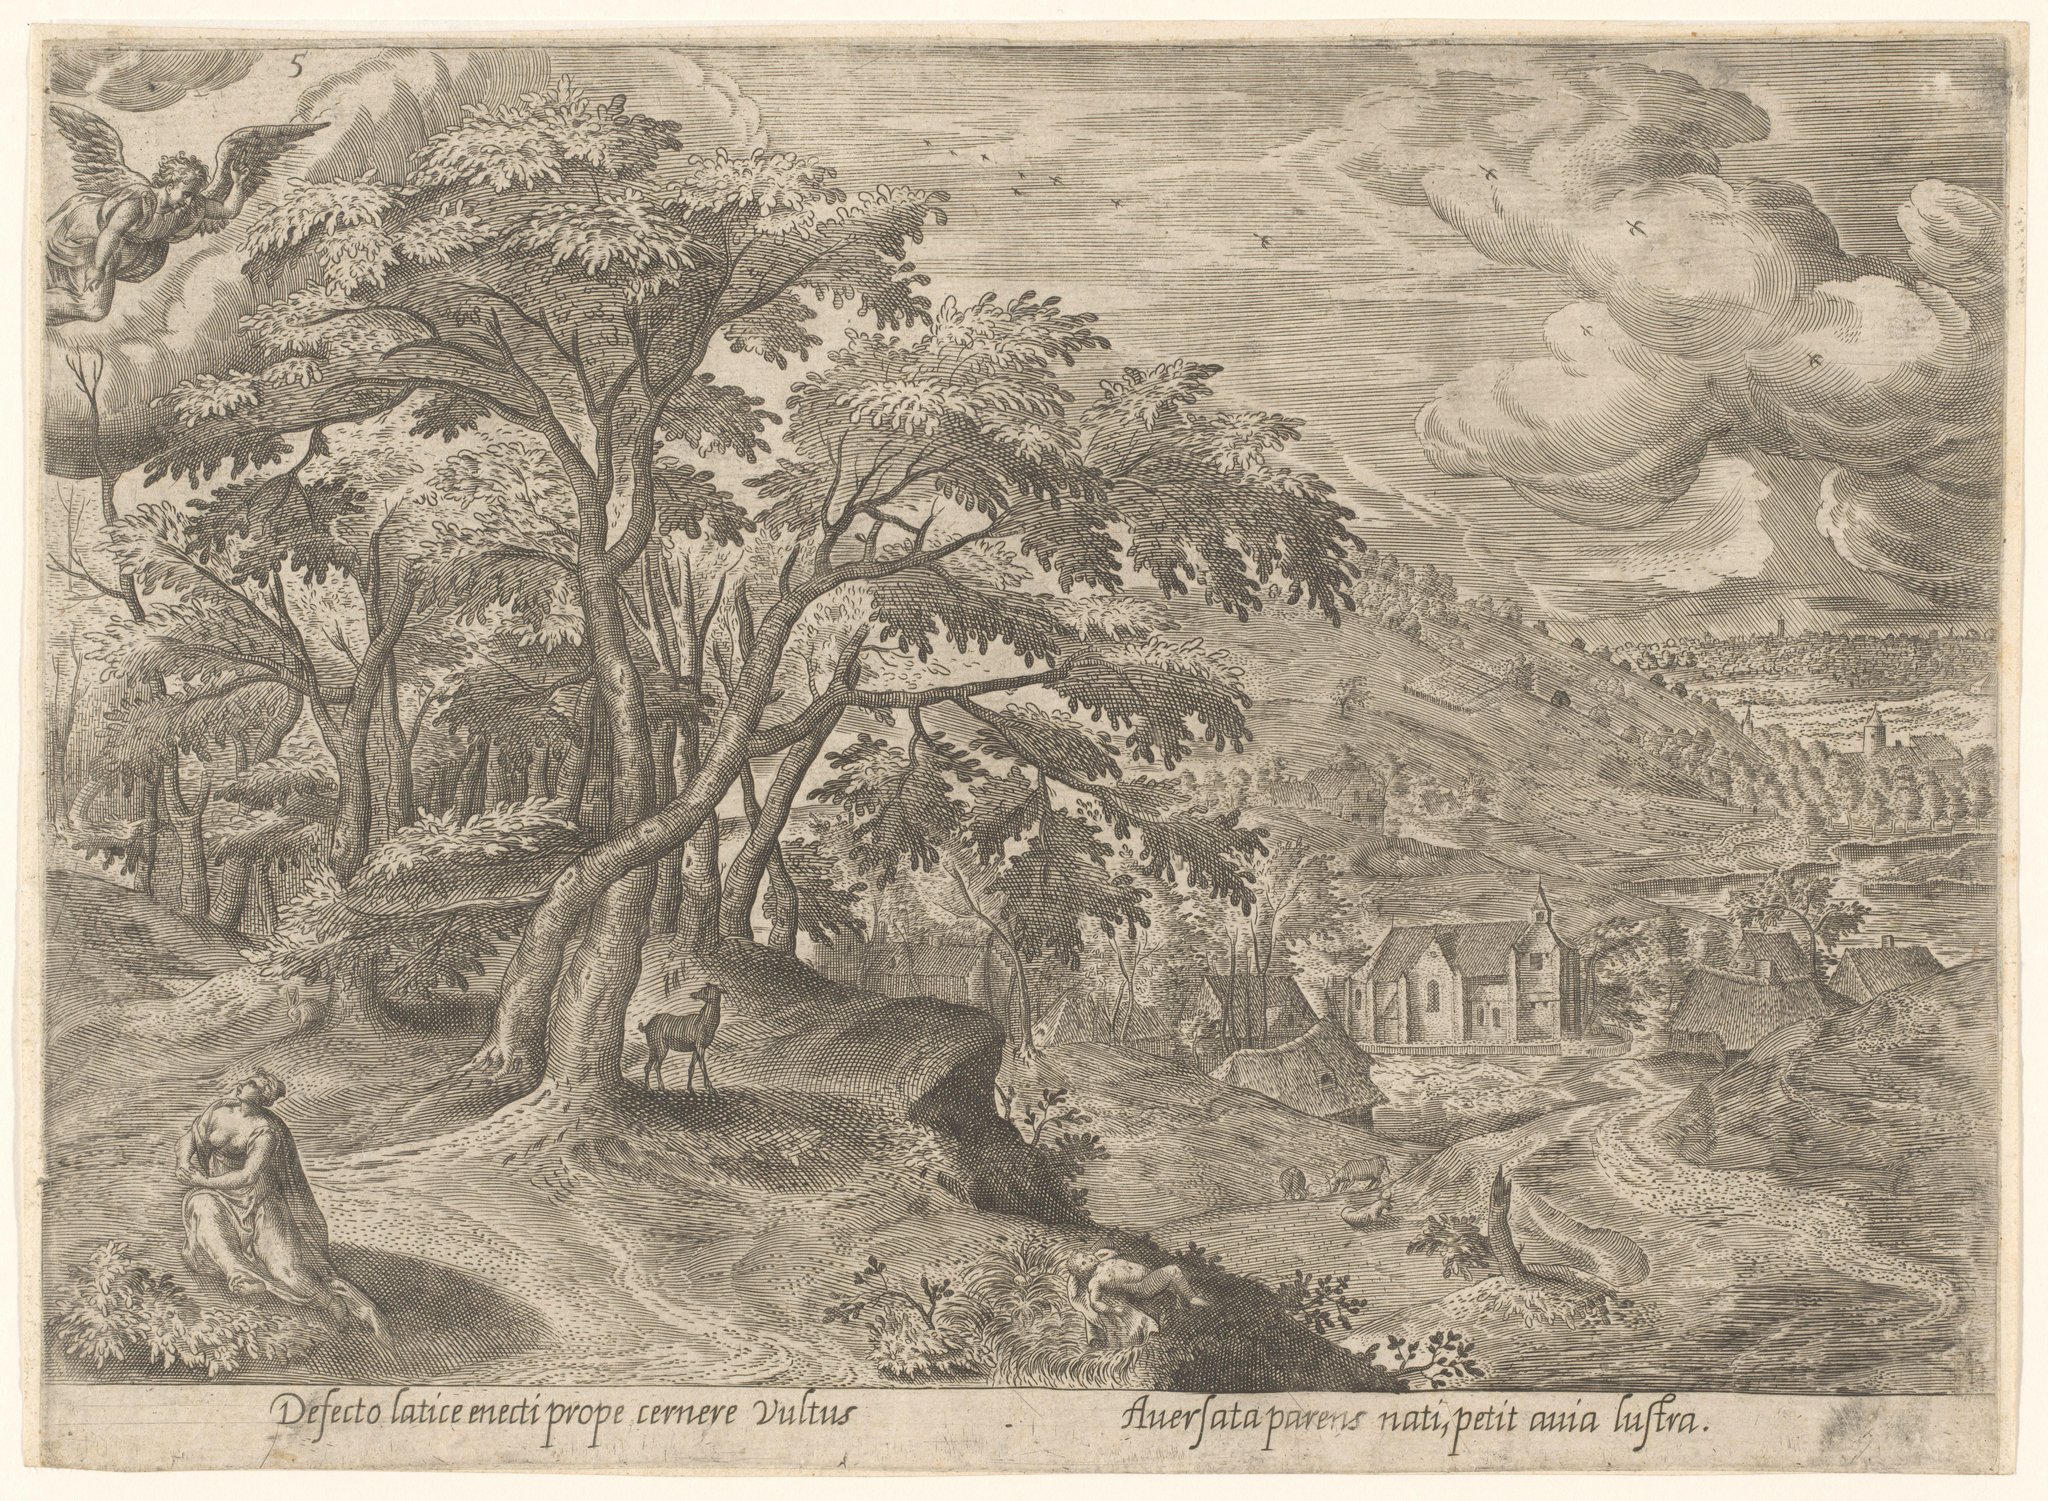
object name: print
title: Scènes uit het leven van de Heilige Geneviève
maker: philips galle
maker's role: print maker, publisher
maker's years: 1537-1612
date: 1575-1600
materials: paper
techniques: engraving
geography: antwerp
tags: female saints (with name)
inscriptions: collector's mark: Lugt 5122, collector's mark: Lugt 2228, collector's mark: Lugt 2760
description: Weids heuvellandschap met links de knielend biddende Heilige Geneviève en een engel in de lucht, rechts ligt haar kind, in het midden een hert. Onderdeel van een serie van zes landschappen met scènes uit het leven van de Heilige Geneviève, beschermheilige van Brabant.